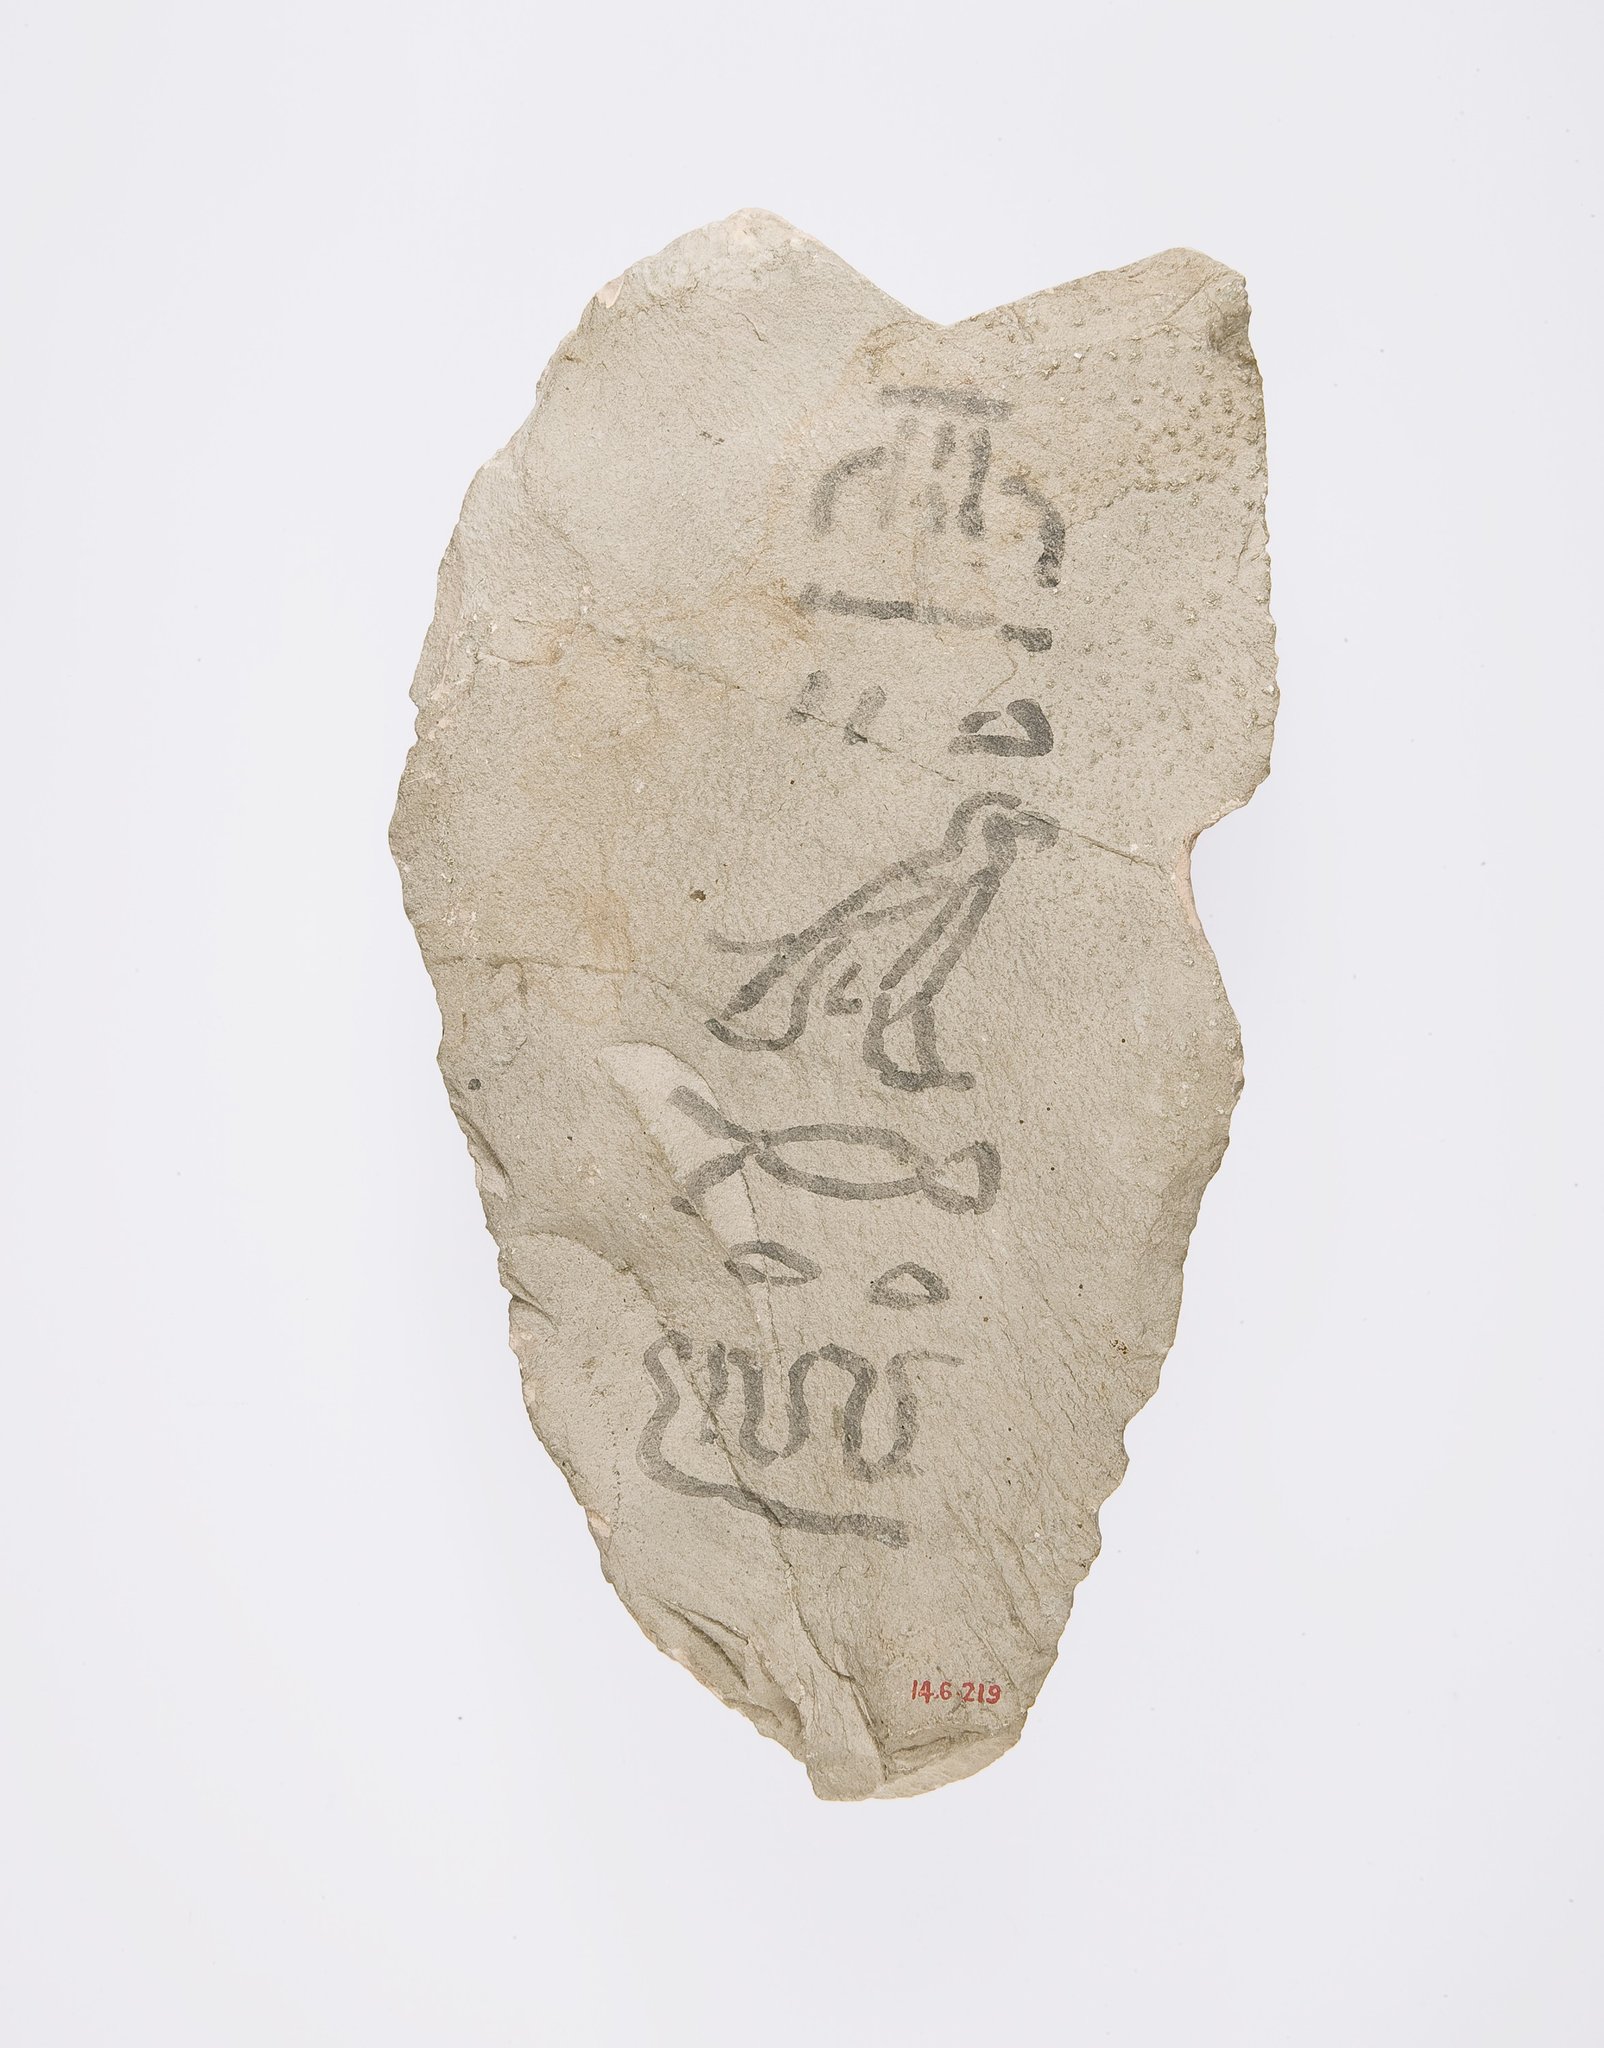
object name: ostracon, hieroglyph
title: Ostracon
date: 1295-1070 BCE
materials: ink, limestone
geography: egypt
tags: hieroglyphs